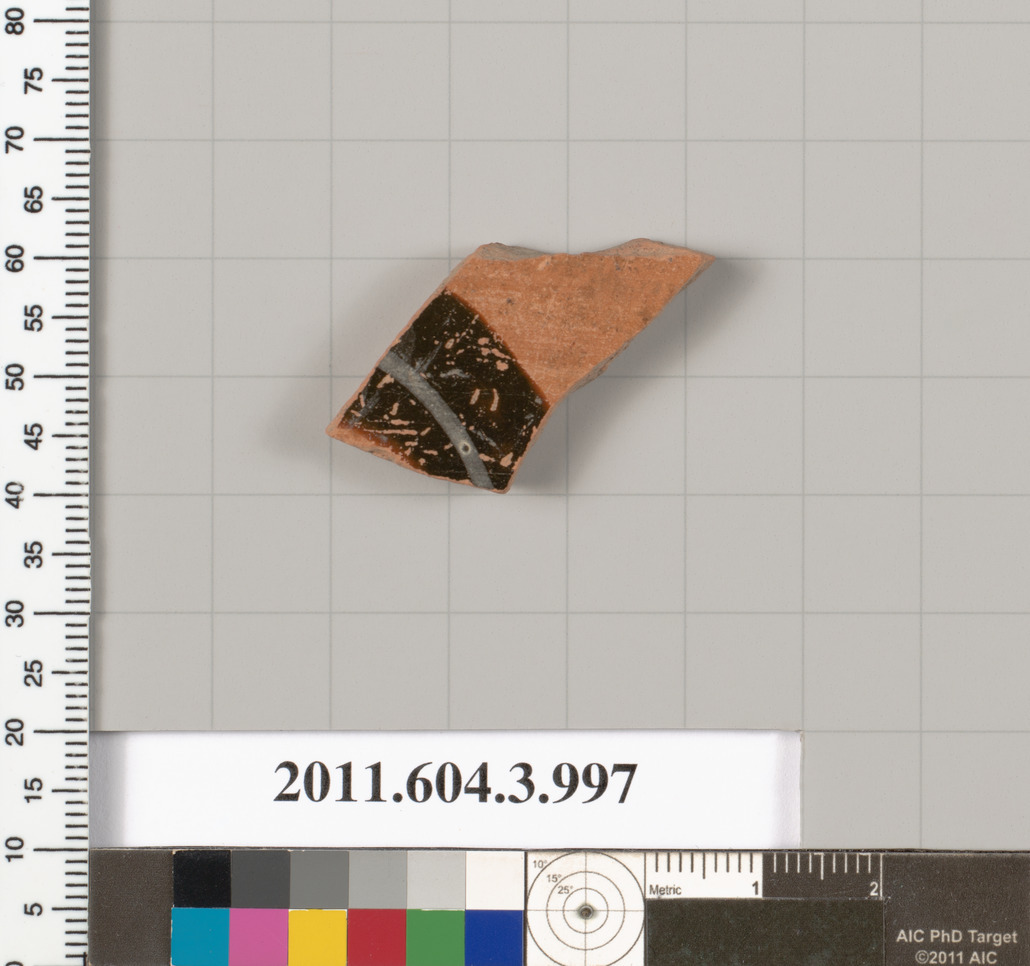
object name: lekanis lid fragment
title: Terracotta fragment of a lekanis lid (covered dish)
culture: greek, attic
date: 575-551 BCE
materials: terracotta